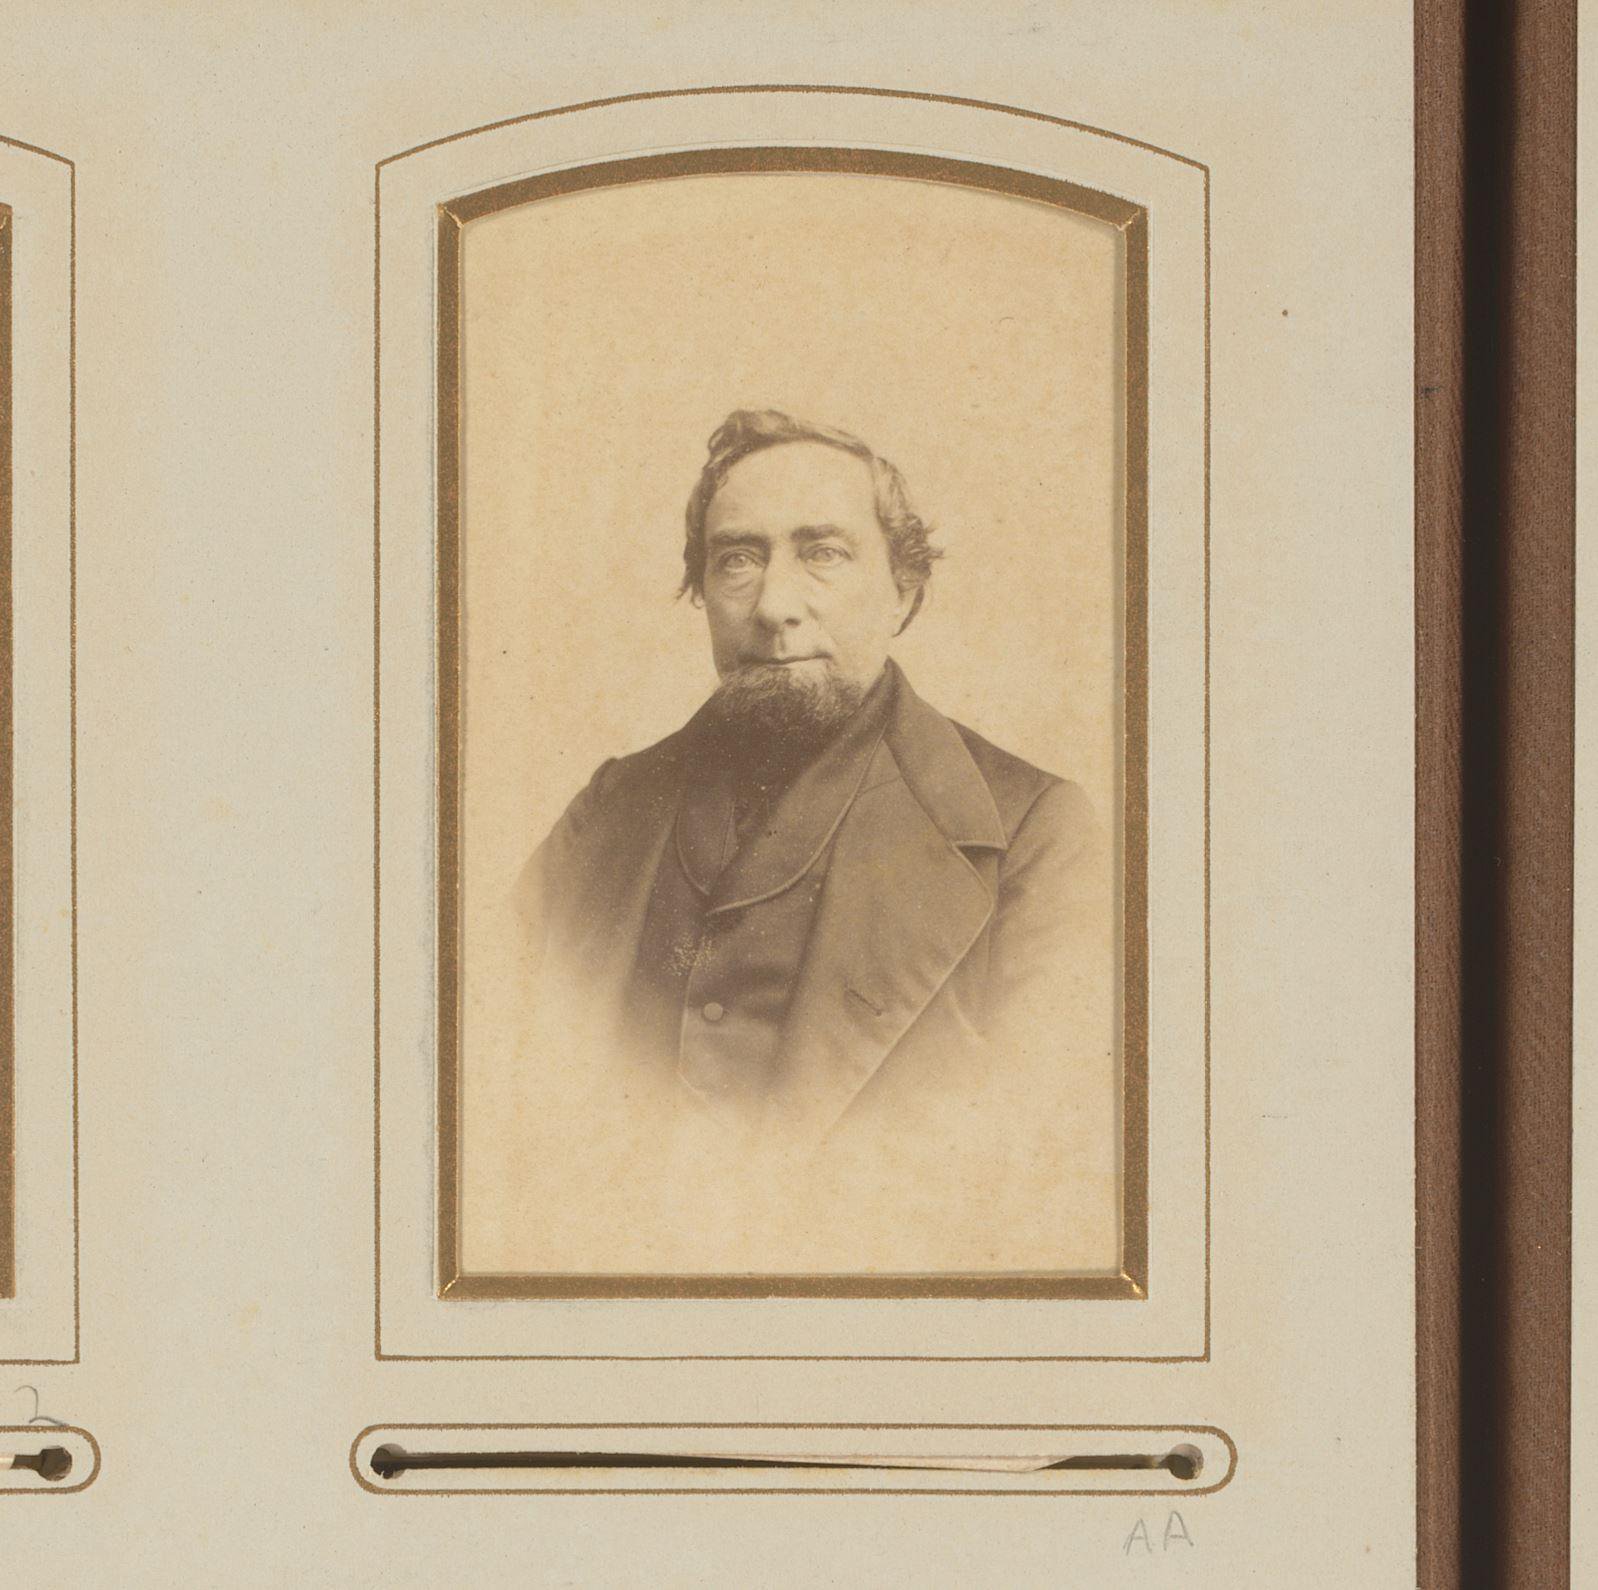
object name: photograph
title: Portret van een man met baard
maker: e. lokje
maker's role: fotograaf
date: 1860-1900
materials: cardboard, photographic support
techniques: albumen print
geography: netherlands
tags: historical persons, beard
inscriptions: inscription: ‘E. LOKJE.PHOT:’